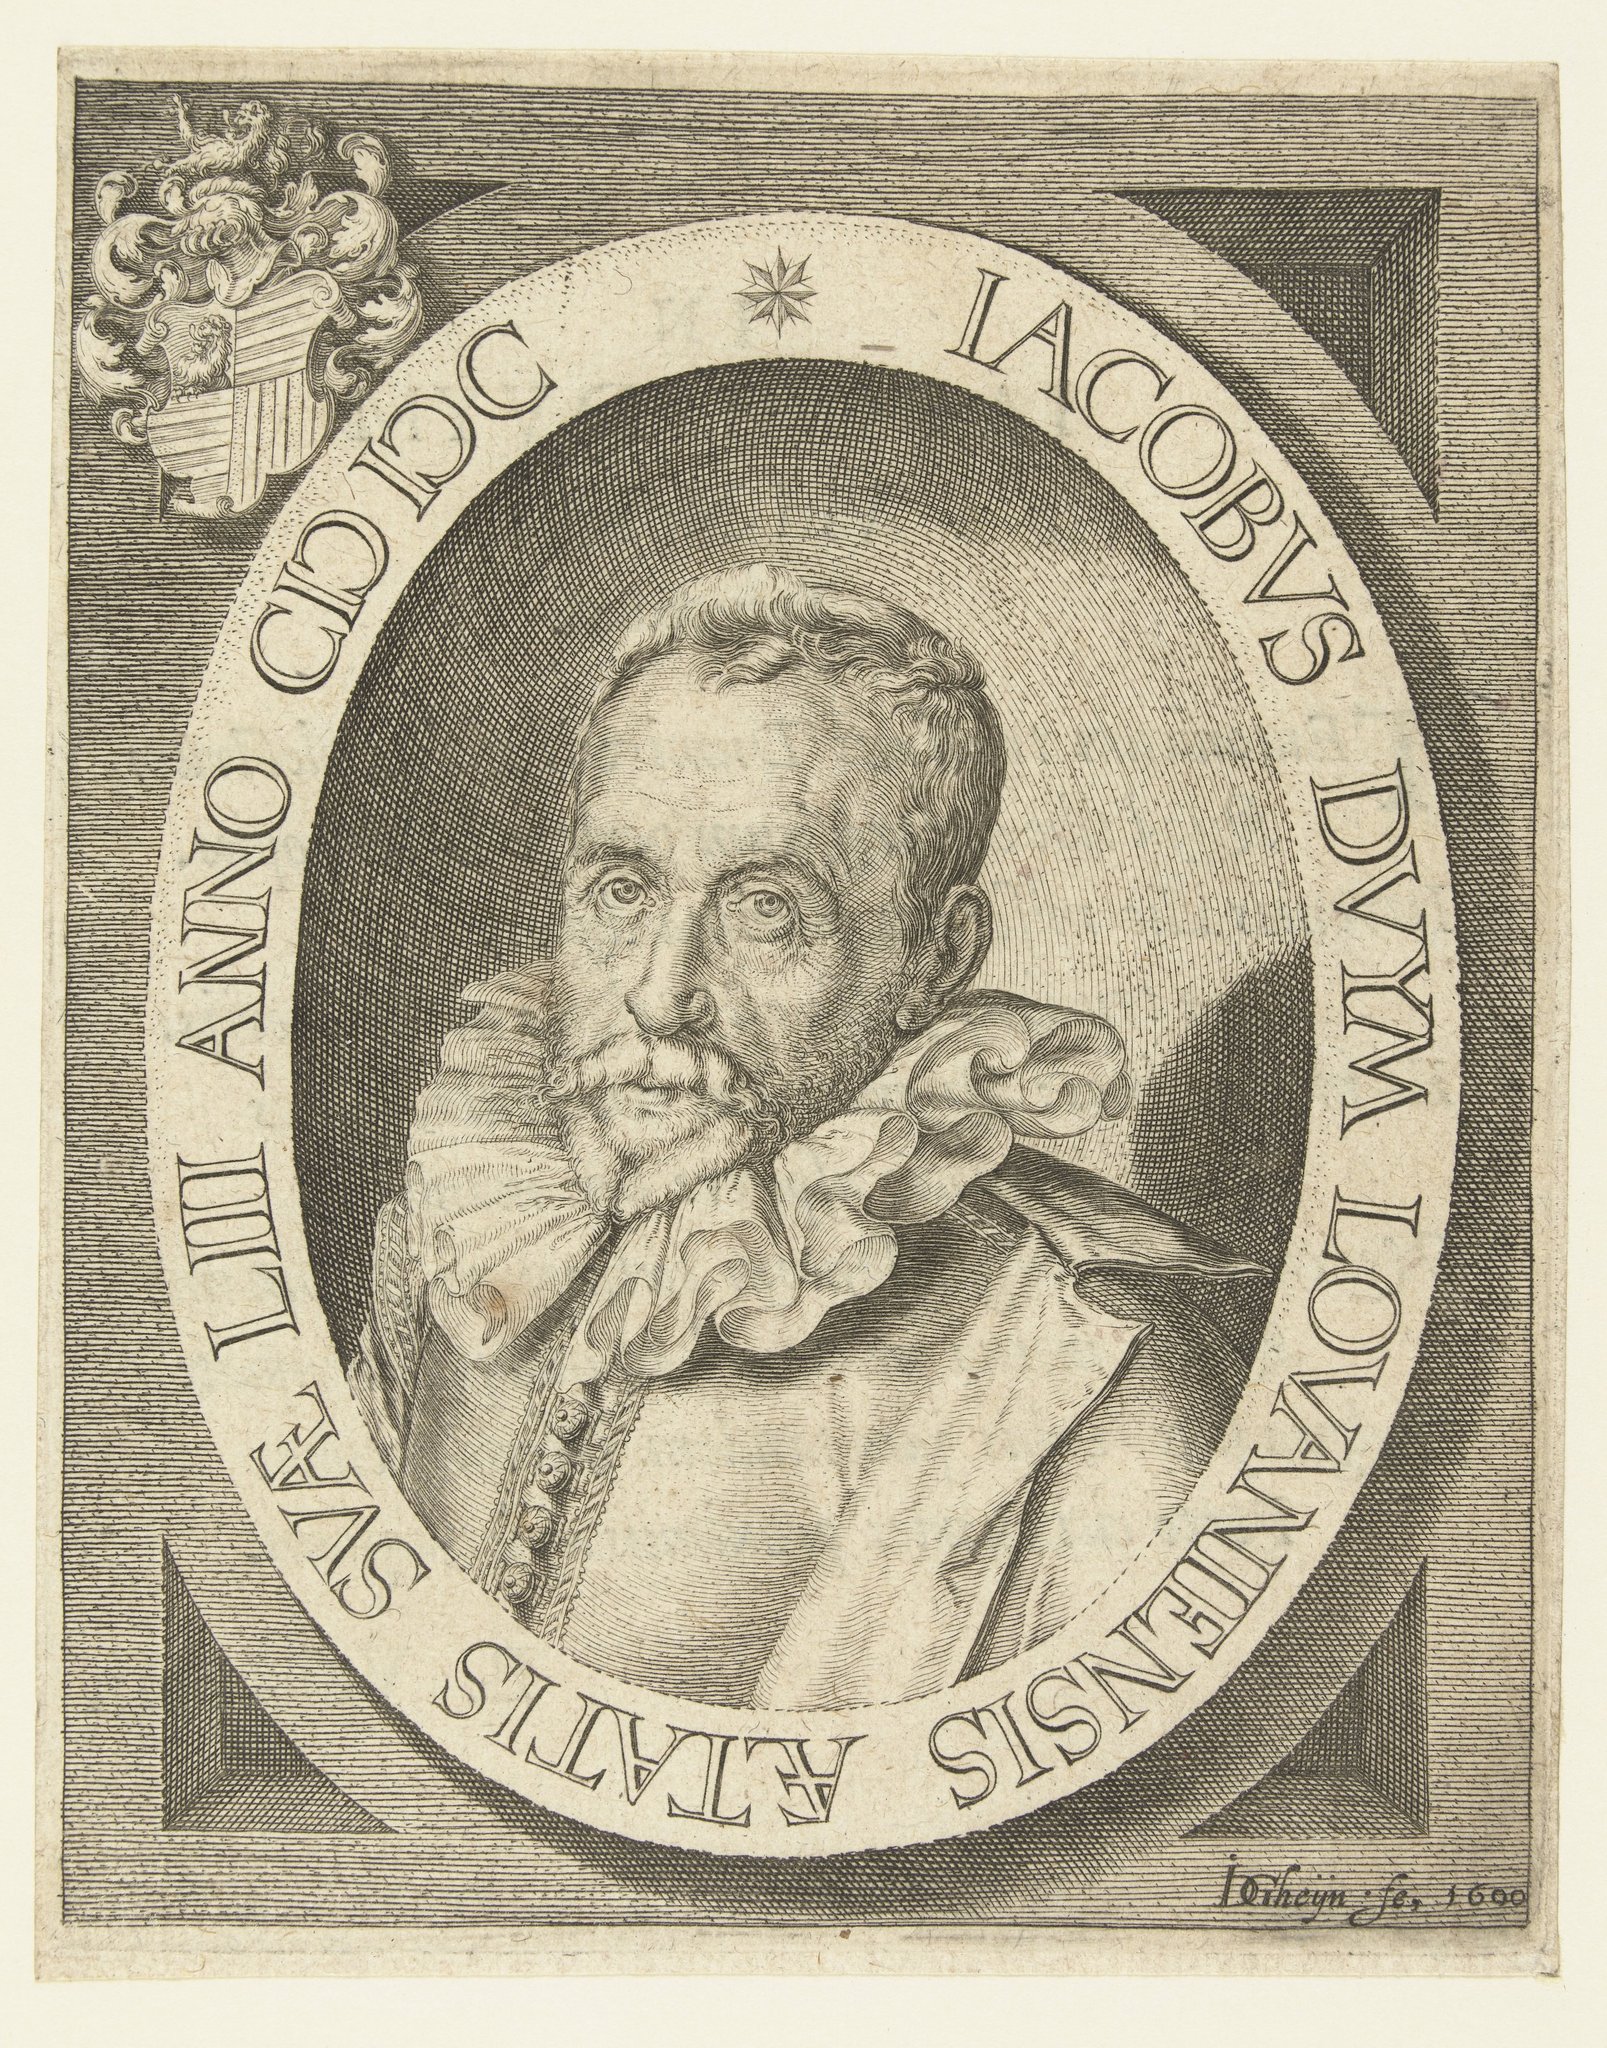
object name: print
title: Portret van Jacobus Duym op 53-jarige leeftijd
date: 1600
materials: paper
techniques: engraving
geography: netherlands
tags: louvain, neck-gear ~ clothing (with name), historical persons, portrait of a writer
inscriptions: collector's mark: Lugt 2228a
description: Buste van Jacob Duym (Leuven, 1547 - Mutsebrouck, tussen 1612 en 1624) op 53-jarige leeftijd, in ovale lijst met naam, leeftijd en datum in randschrift. Brede los geplooide kraag om de hals. Links naast het ovaal zijn familiewapen. Op de achterzijde een tienregelig Latijns gedicht over Duym in boekdruk. Duym was Nederlandstalige dichter, jurist en historicus, lid van de rederijkers in Leiden en gehuwd met Elizabeth Craechs.